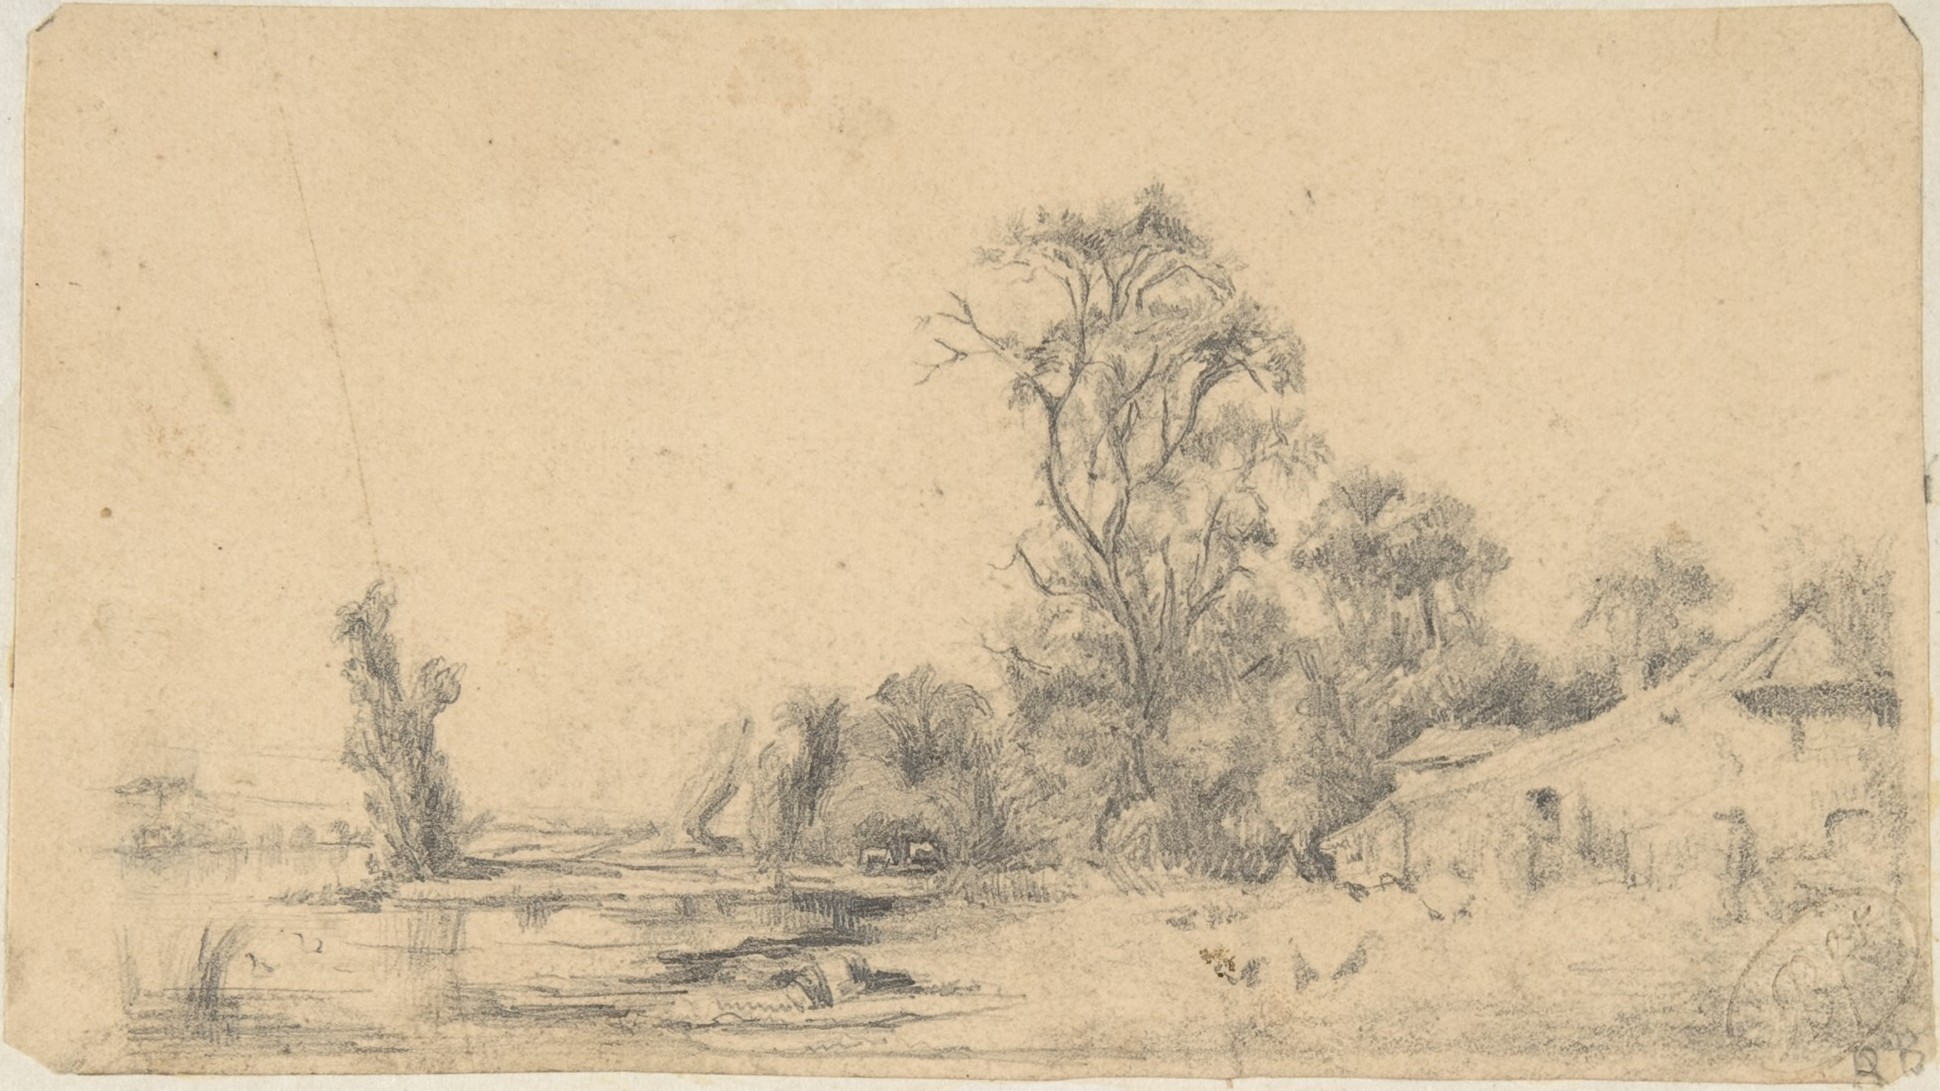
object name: drawing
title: Banks of the Seine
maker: rodolphe bresdin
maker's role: artist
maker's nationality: french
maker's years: 1822-1885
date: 1822-1885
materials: graphite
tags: houses,rivers,trees